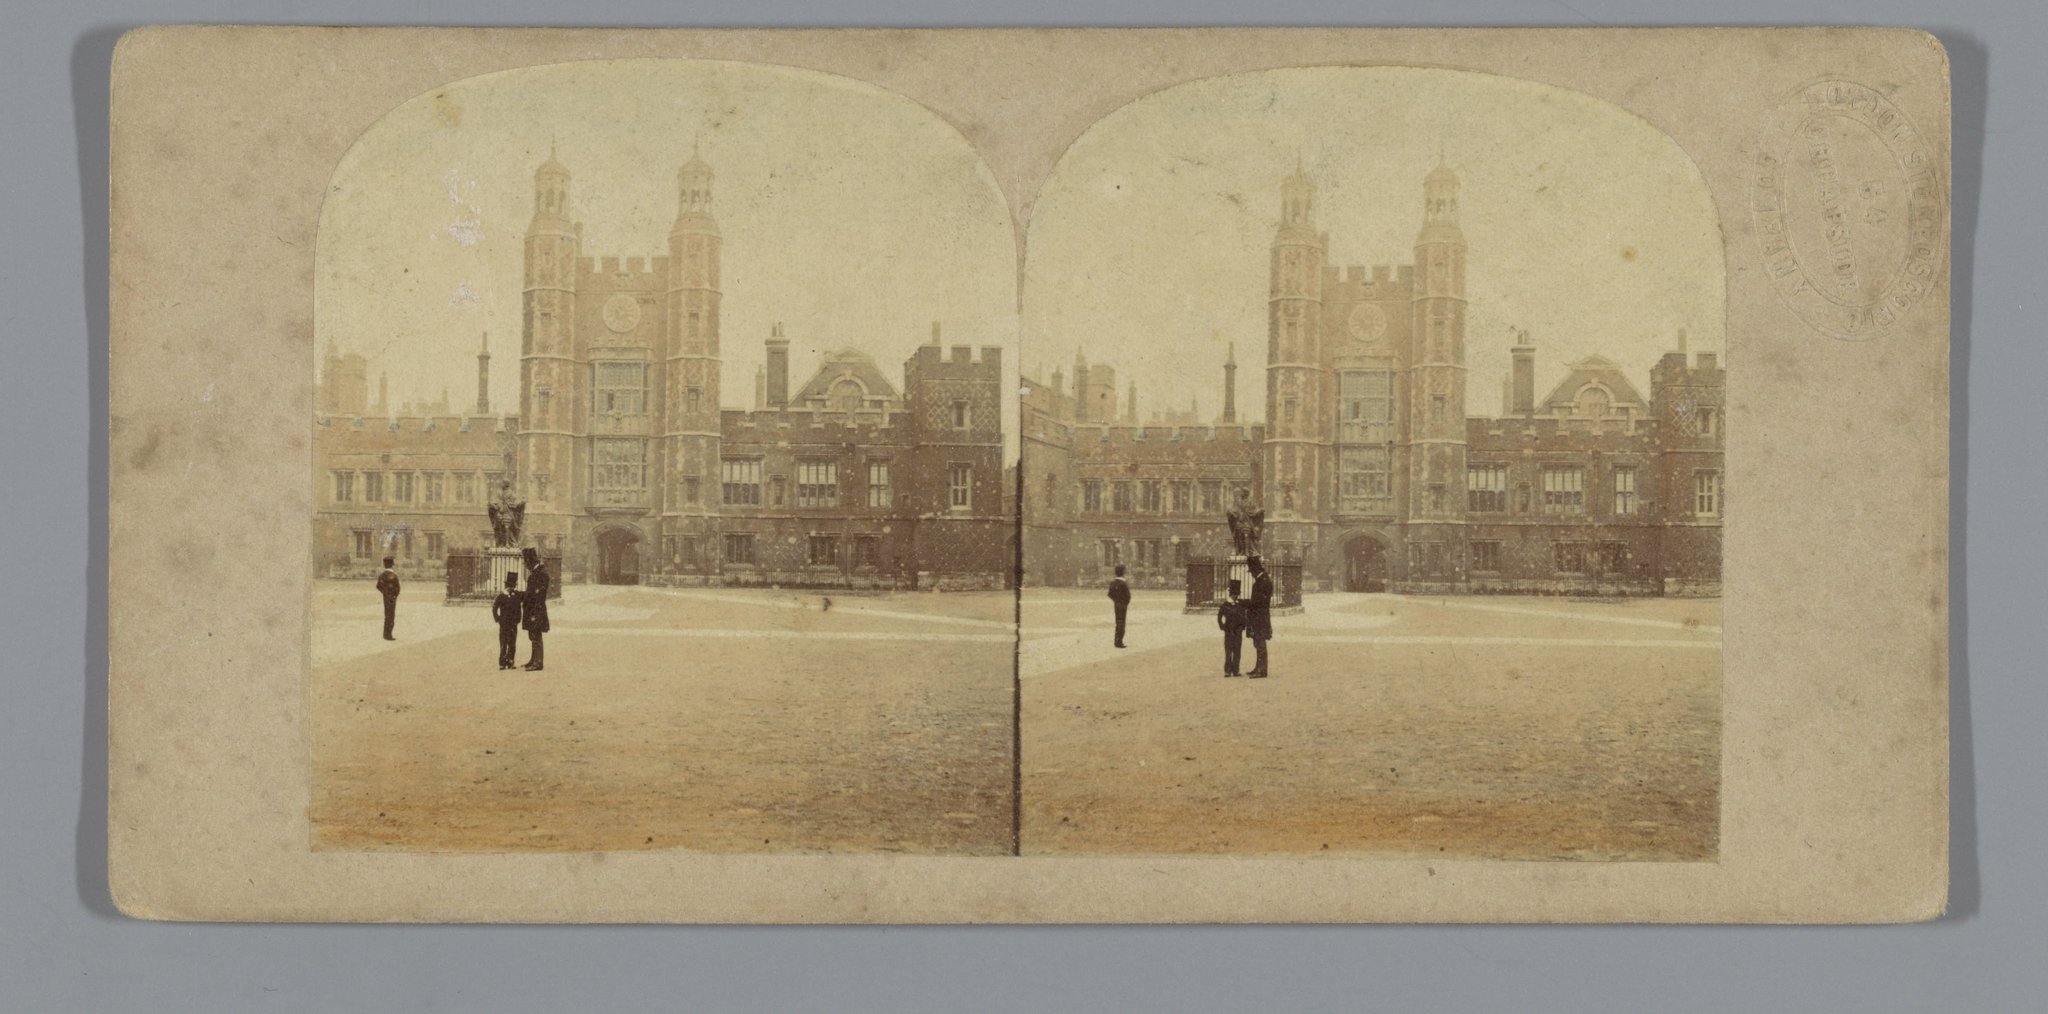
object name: stereograph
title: Eton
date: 1856-1859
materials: cardboard, photographic support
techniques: albumen print, hand coloring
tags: university building, college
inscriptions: name: ‘London Stereoscopic Company 54 Cheapside’